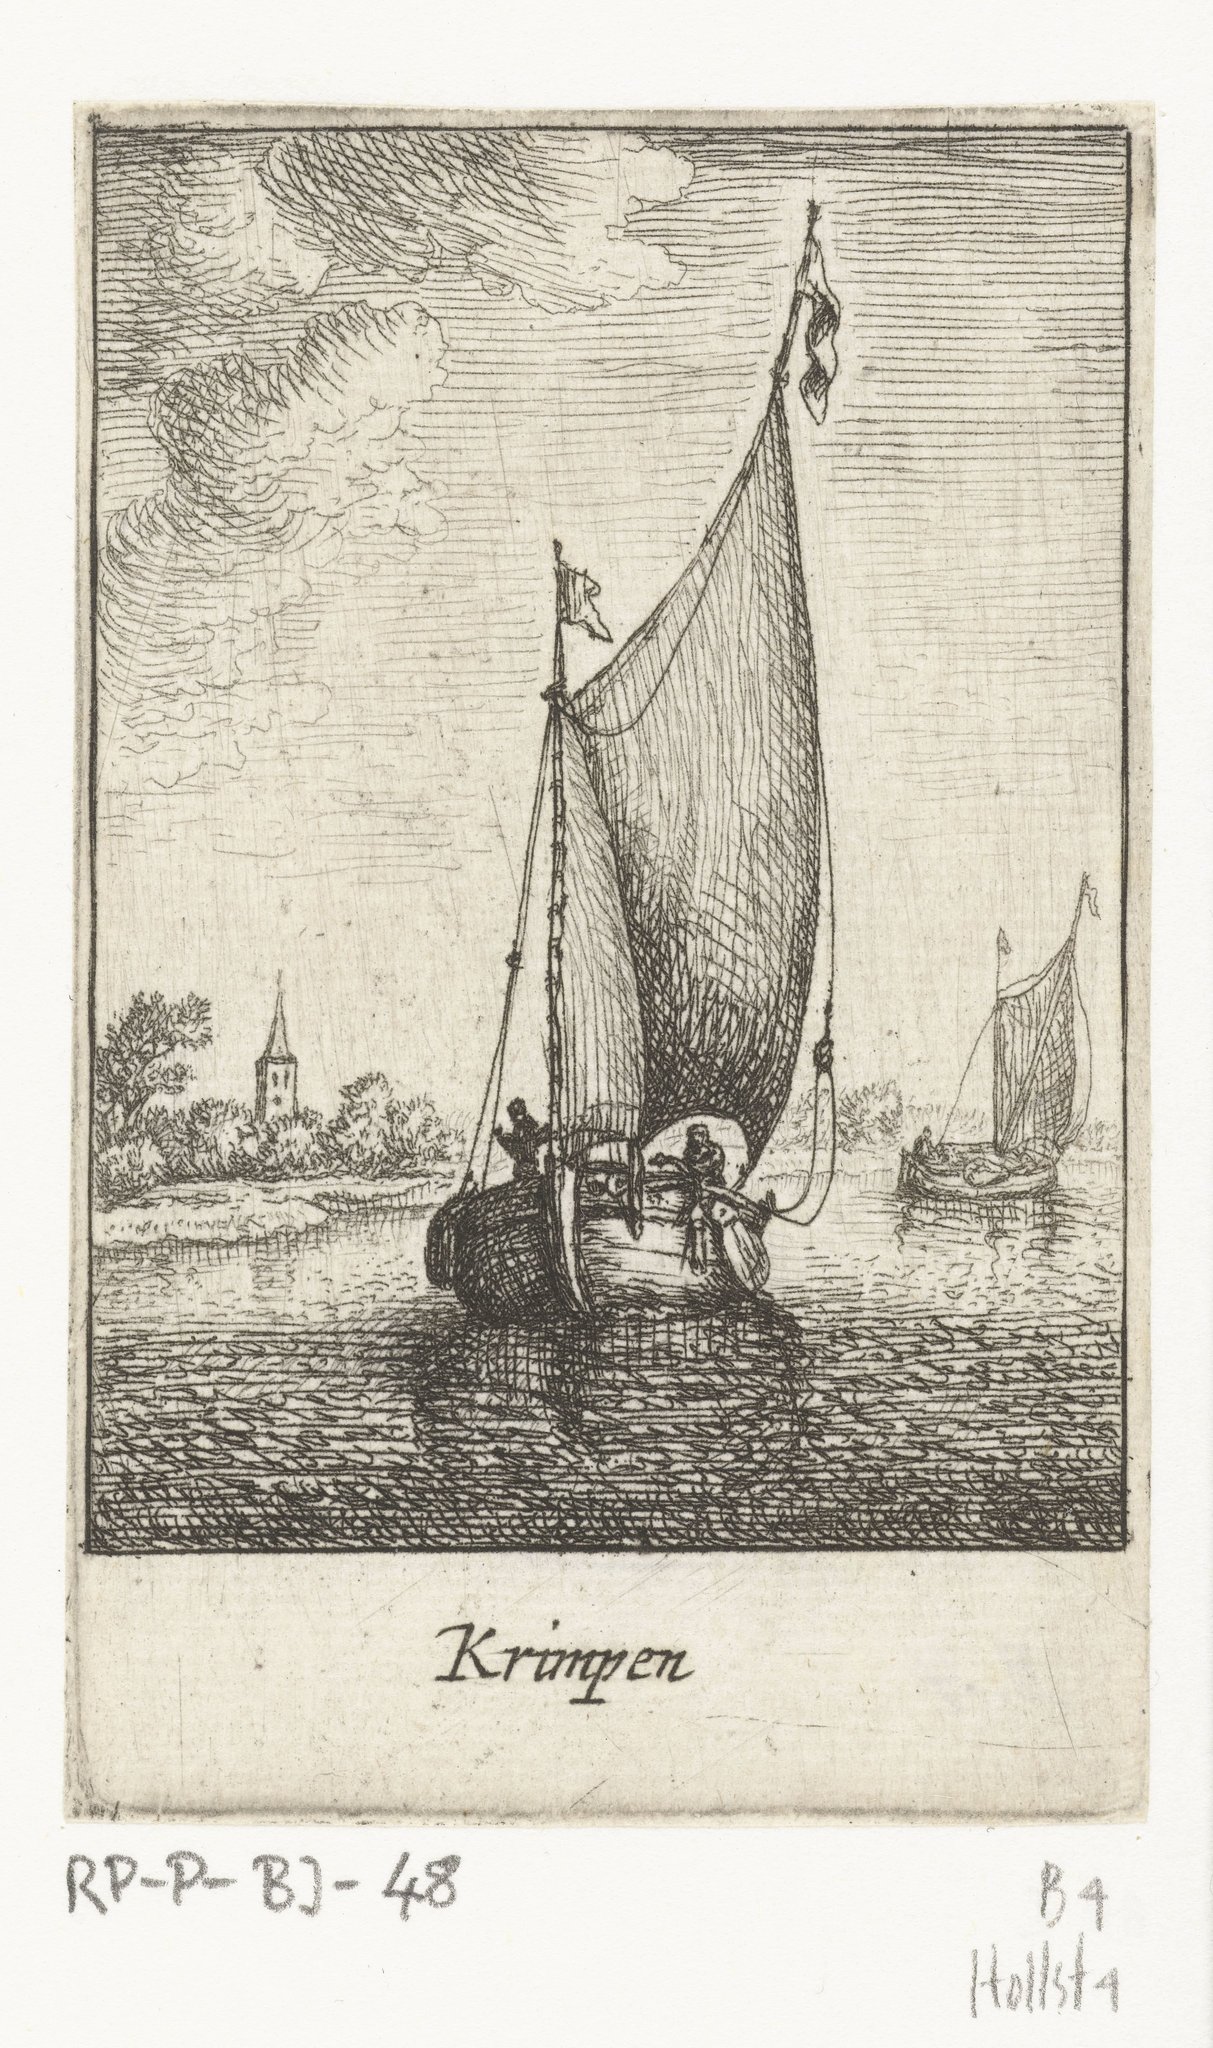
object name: print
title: Gezicht op Krimpen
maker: jan van almeloveen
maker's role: draughtsman, print maker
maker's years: 1652-1683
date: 1662-1683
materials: paper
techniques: etching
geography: netherlands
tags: village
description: Gezicht op Krimpen aan de Lek of aan den IJssel vanuit het water. Prent uit een serie van twaalf dorpsgezichten van Nederlandse plaatsen in de buurt van Utrecht met boten op de voorgrond.